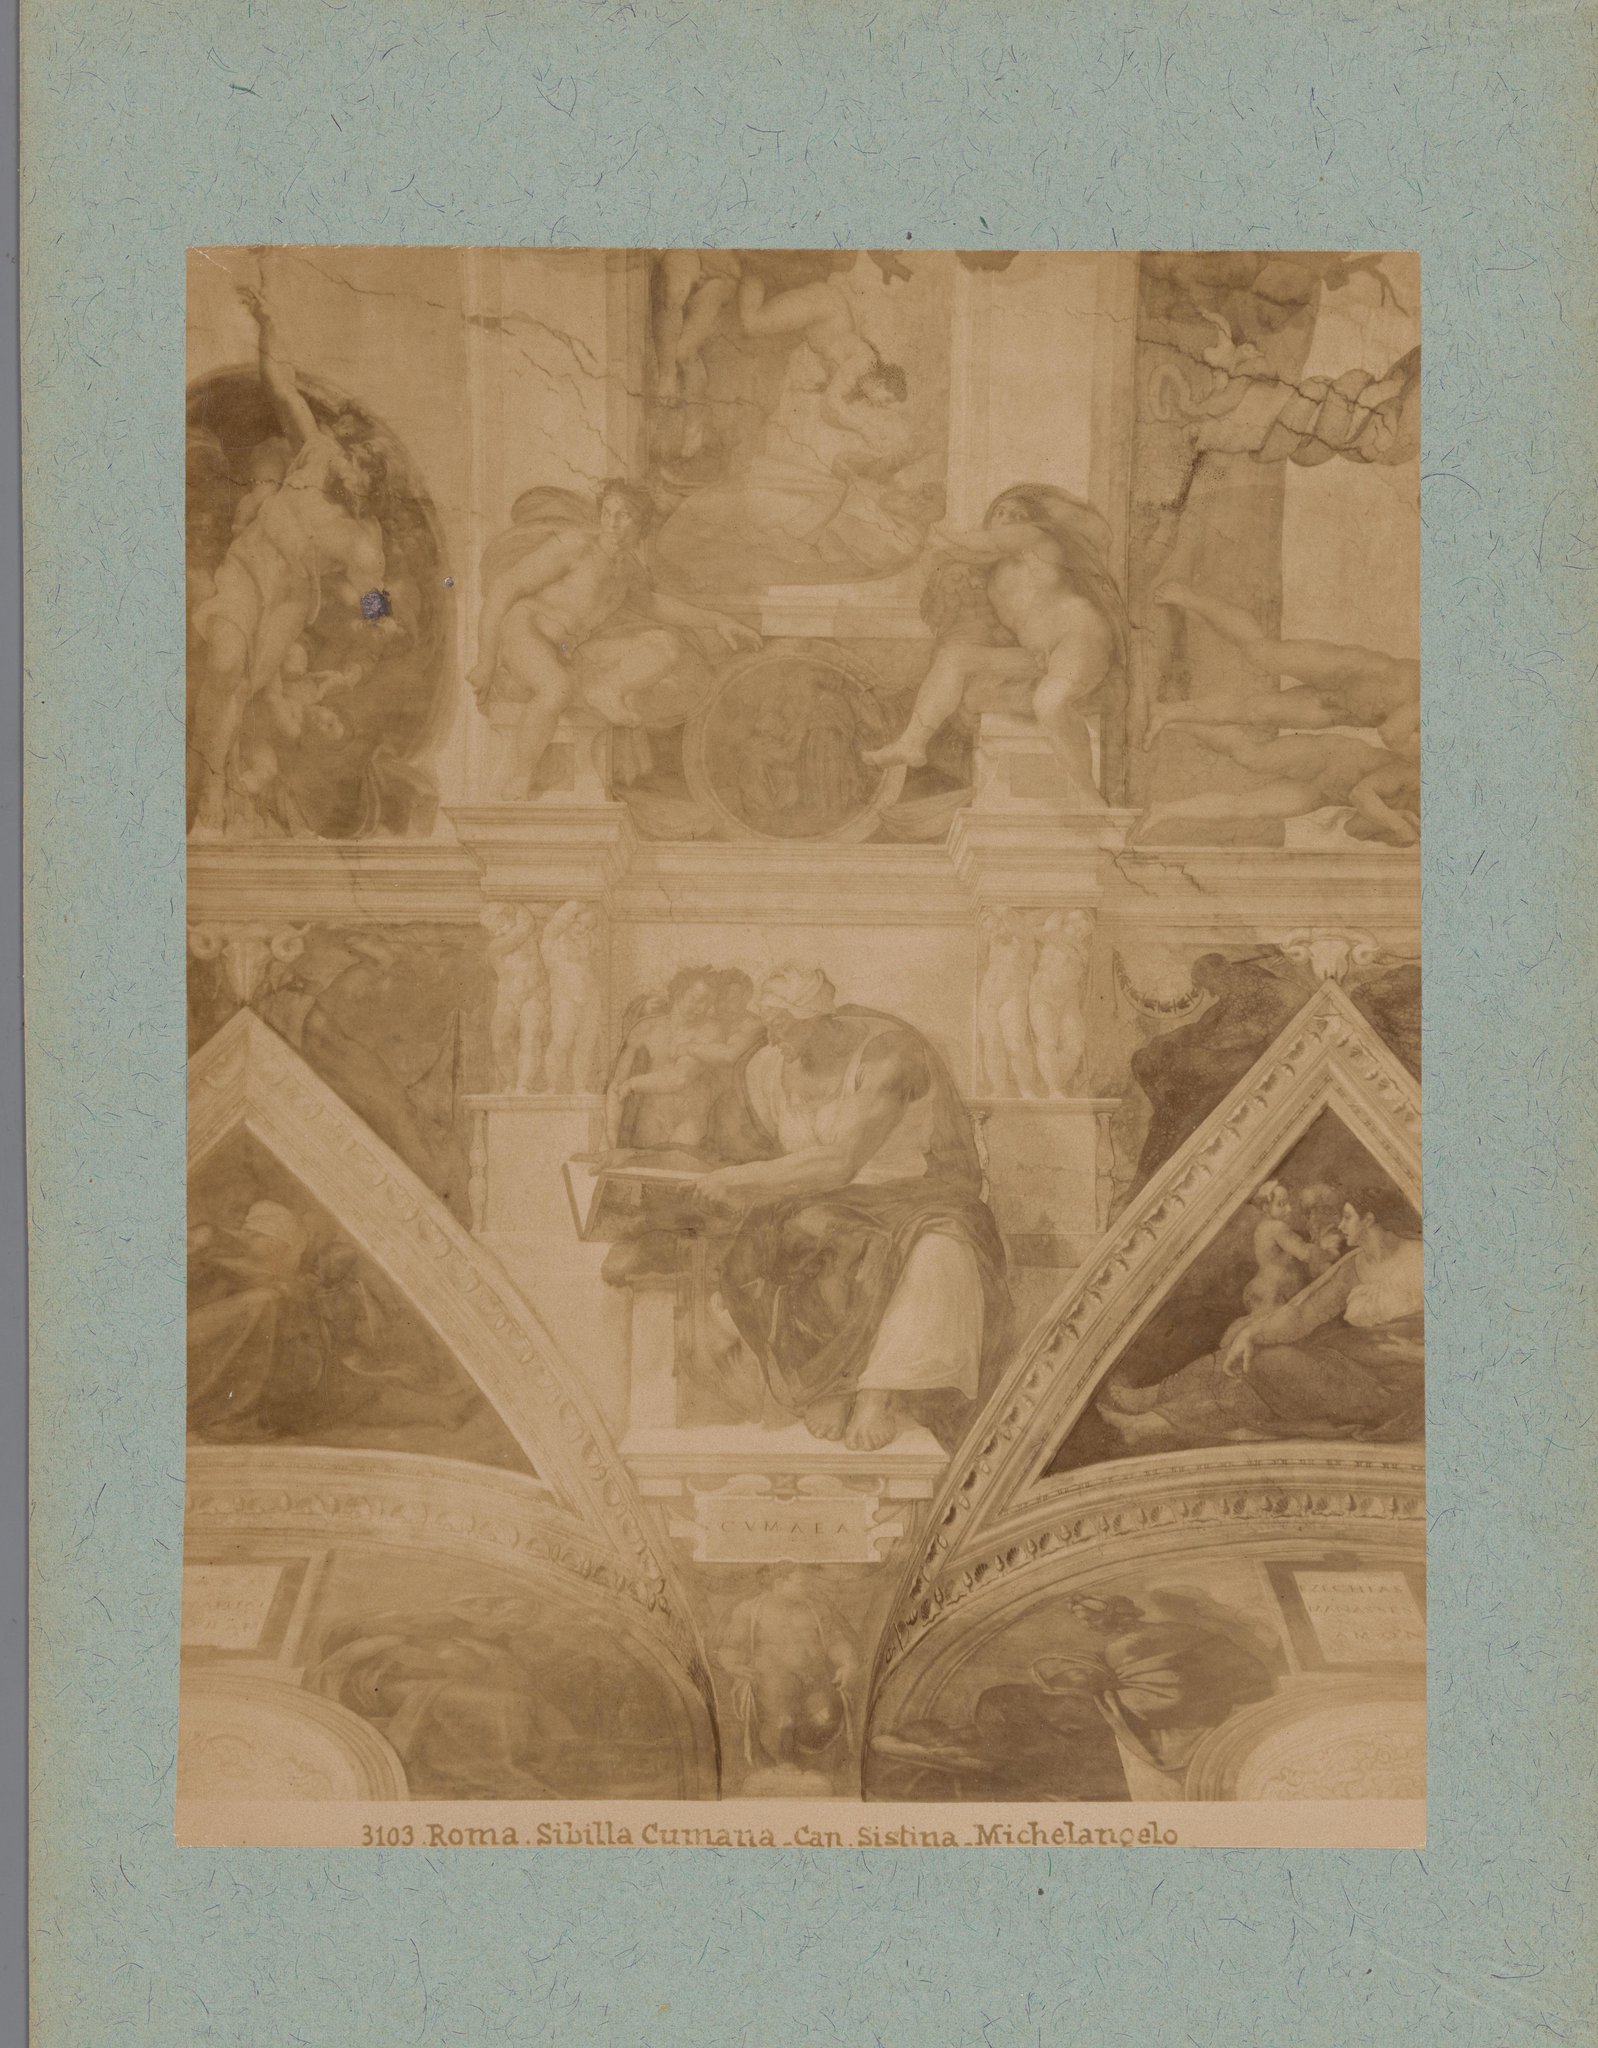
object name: reproduction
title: Fotoreproductie van het fresco Sibille van Cumae naar Michelangelo in de Sixtijnse kapel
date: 1851-1900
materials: cardboard, paper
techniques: albumen print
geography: vatican city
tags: picture, painting, wall-covering, cumaean sibyl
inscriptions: number: ‘3103.’, collector's mark: ‘VOSMAER’